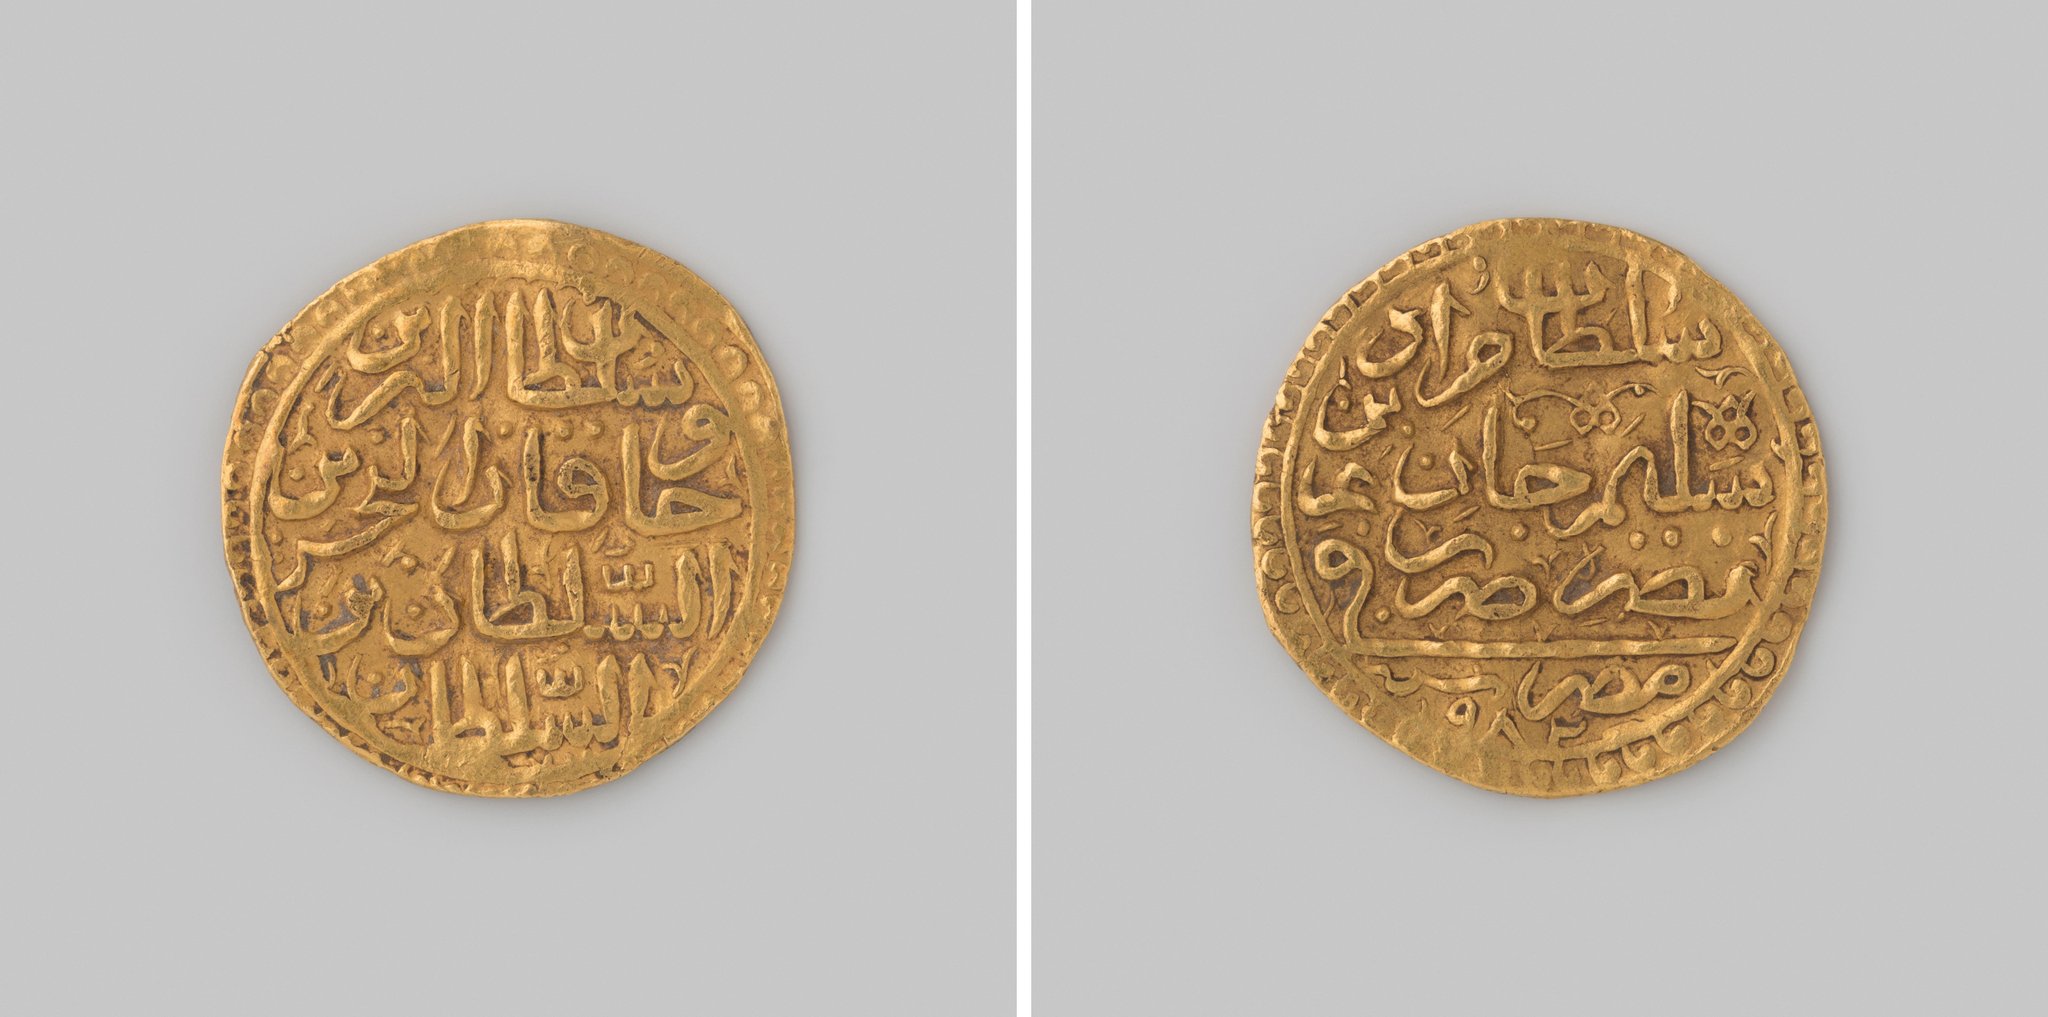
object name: coin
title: Egypte, sequin, Ottomaanse sultan Murad III, 982-1003 [=1574-1595]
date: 1574-1595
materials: gold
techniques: striking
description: Gouden munt. Voorzijde: binnen cirkel vierregelig opschrift in Arabische letters. Keerzijde: binnen cirkel vierregelig opschrift in Arabische letters.